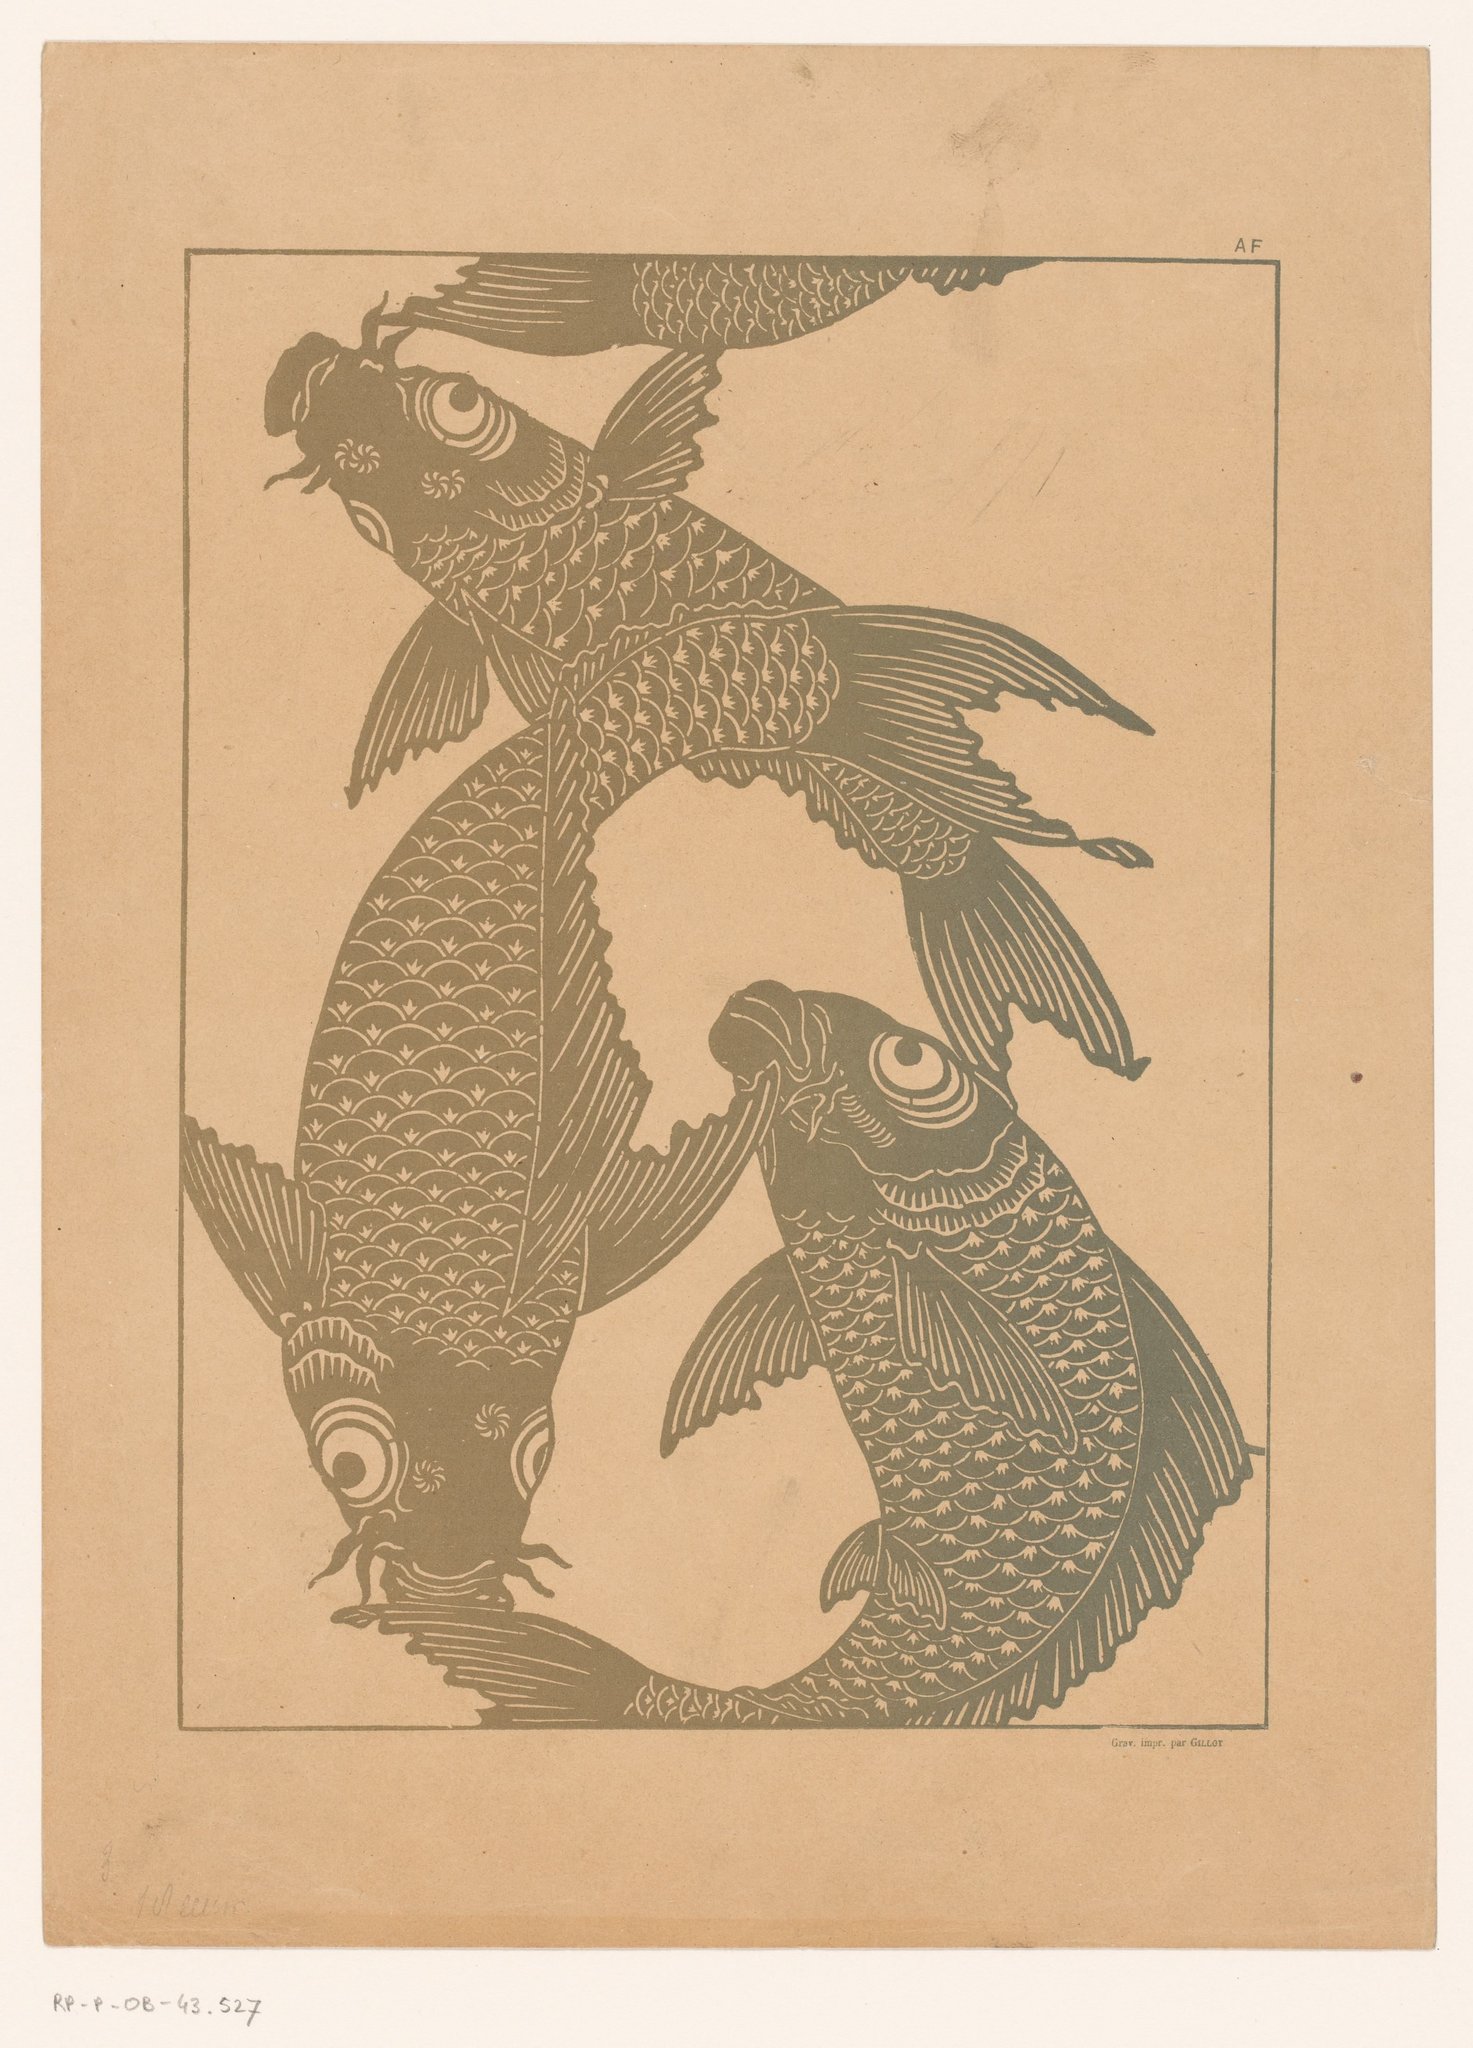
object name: print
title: Karpers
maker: firmin gillot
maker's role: print maker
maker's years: 1820-1872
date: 1830-1872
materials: paper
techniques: photolithography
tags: bony fishes: carp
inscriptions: collector's mark: Lugt 3937, collector's mark: Lugt 2228